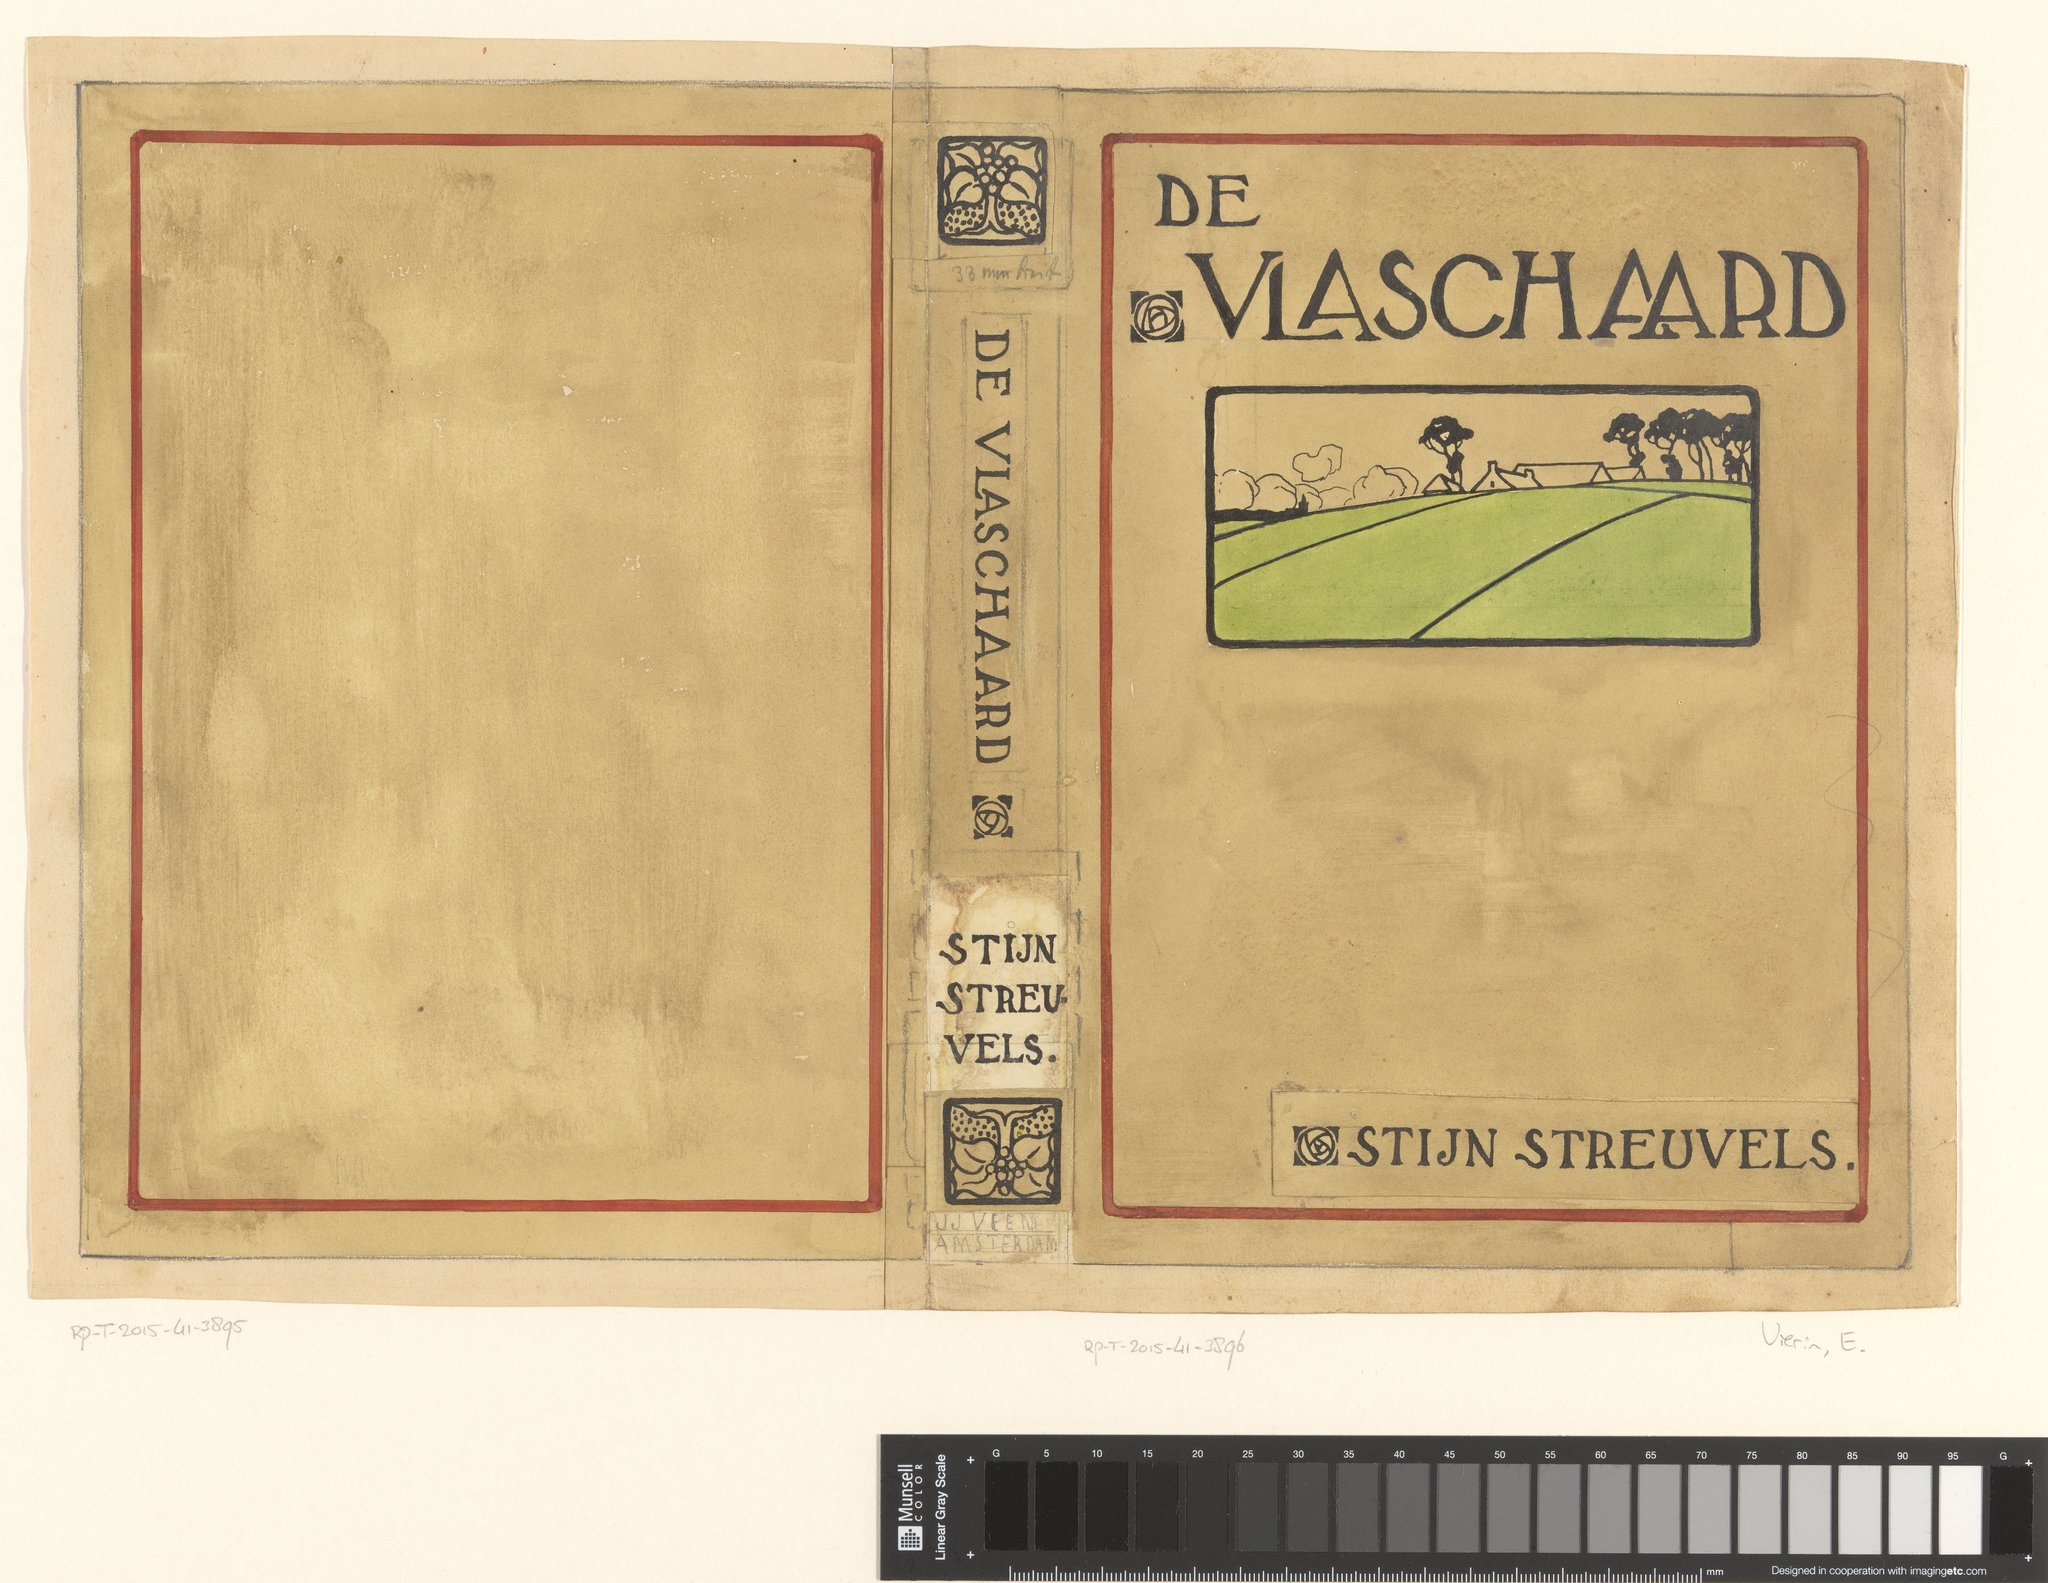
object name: drawing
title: Bandontwerp voor: Stijn Streuvels, De vlaschaard, 1907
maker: emmanuel viérin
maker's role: draughtsman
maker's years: 1869-1954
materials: ink, paper, pencil, watercolor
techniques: brush, pen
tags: farm or solitary house in landscape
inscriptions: :, collector's mark: Lugt 2228a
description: Weilanden met bomen en een boerderij. Op de boekrug twee vierkanten met daarin een gestileerde boom.